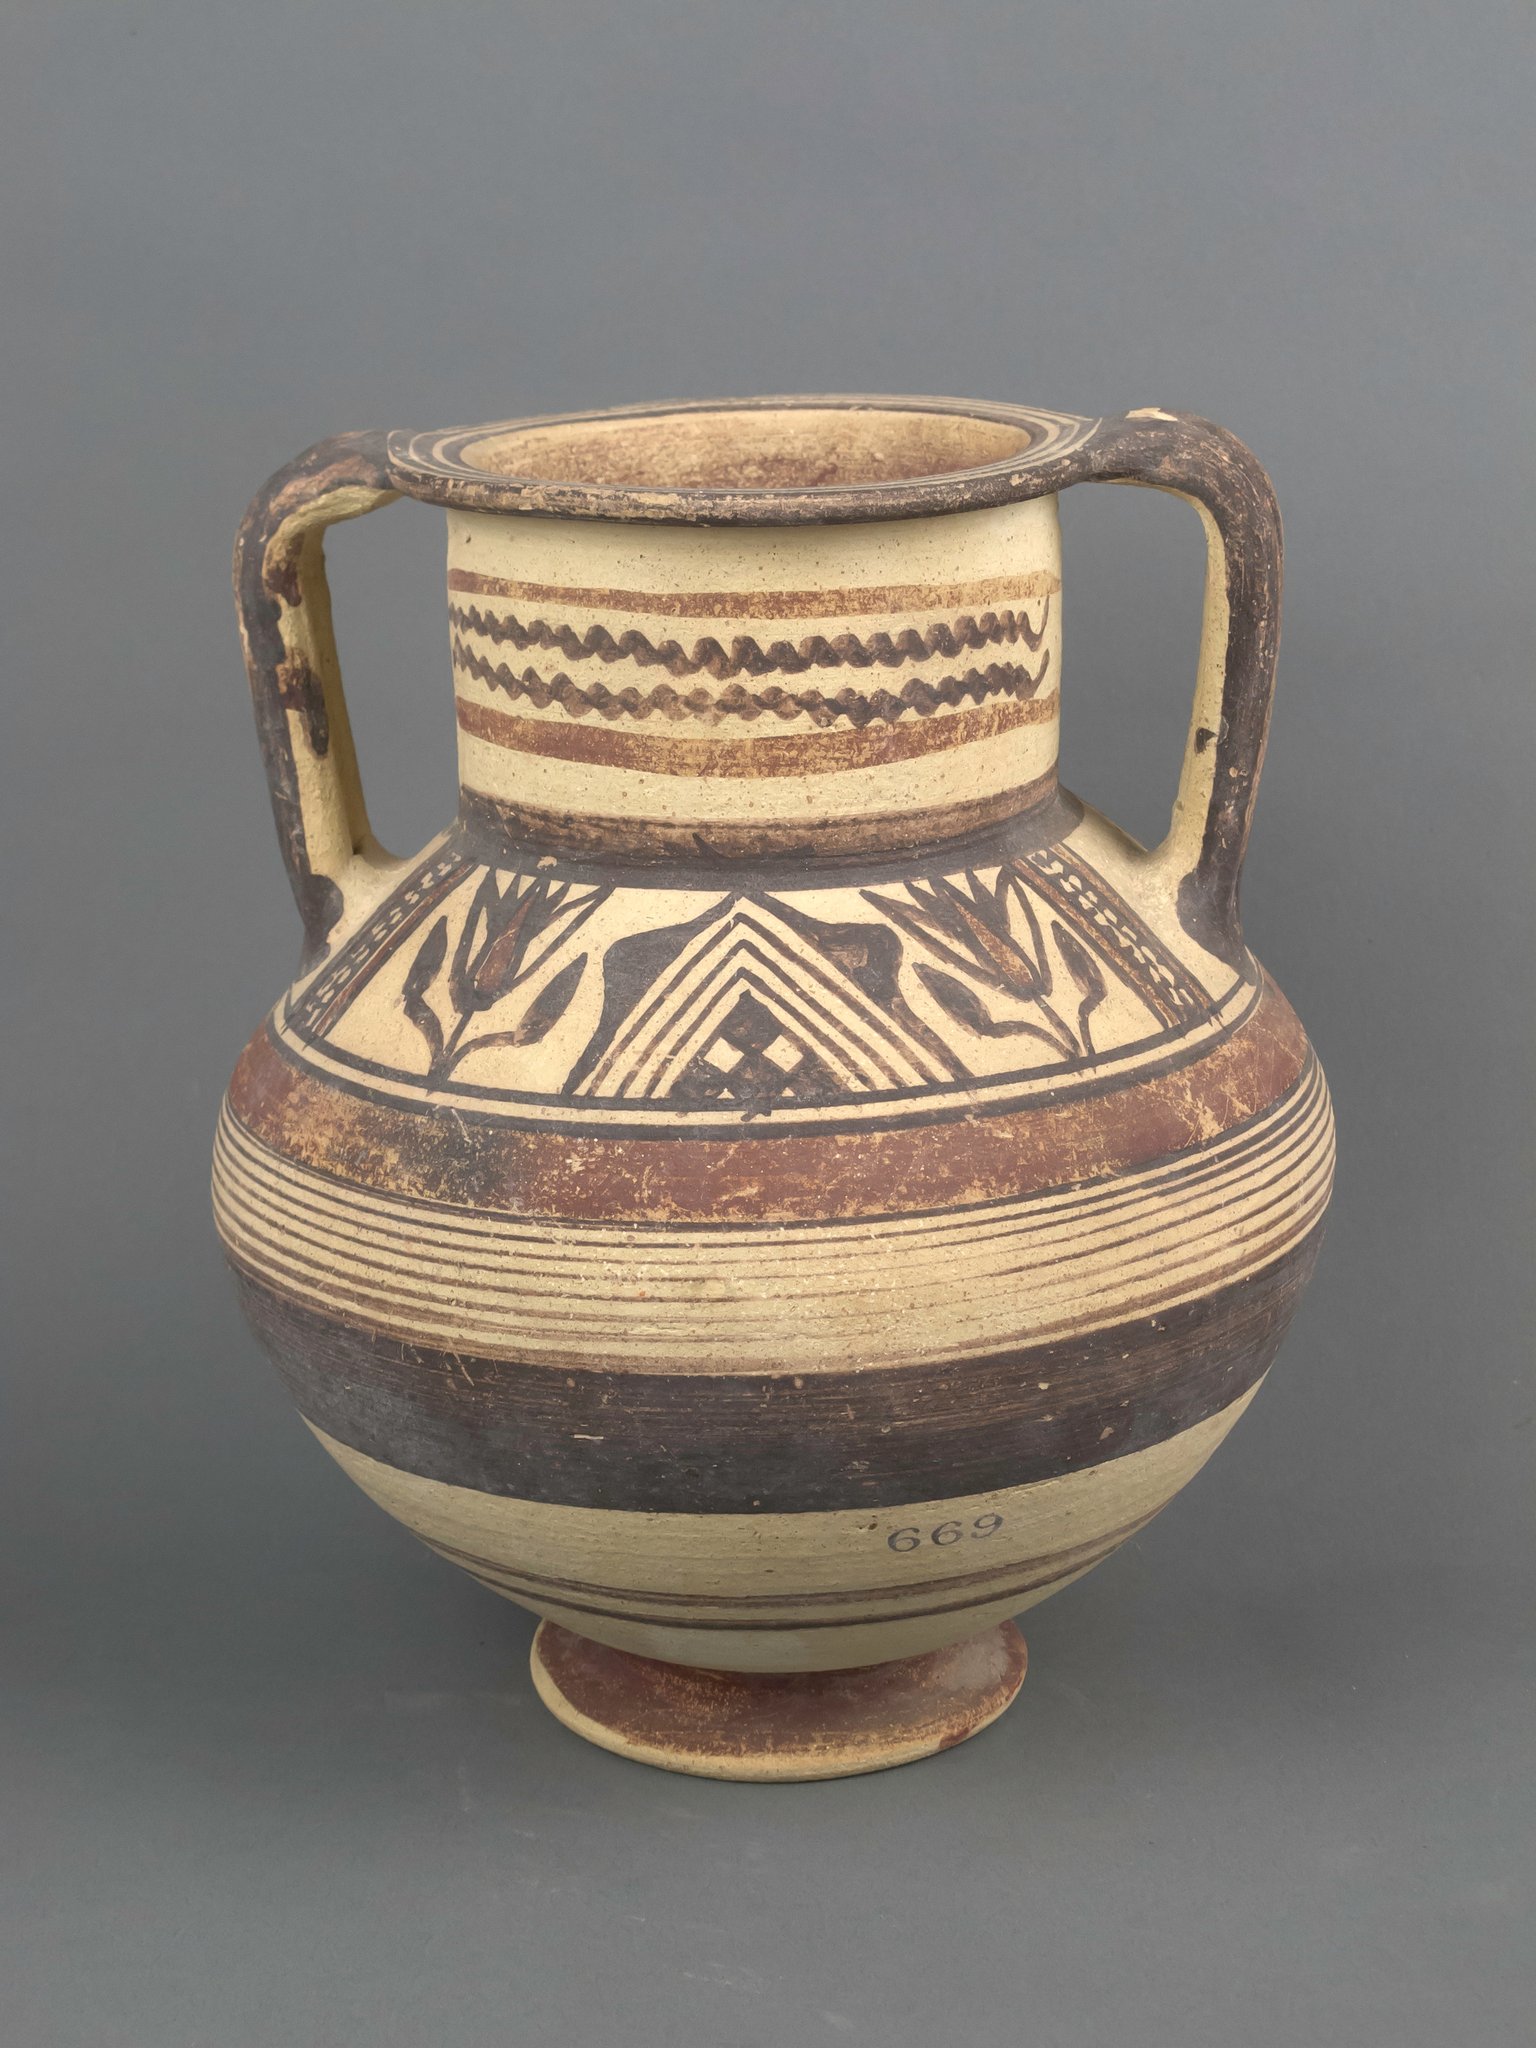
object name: amphora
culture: cypriot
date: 750-600 BCE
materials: terracotta